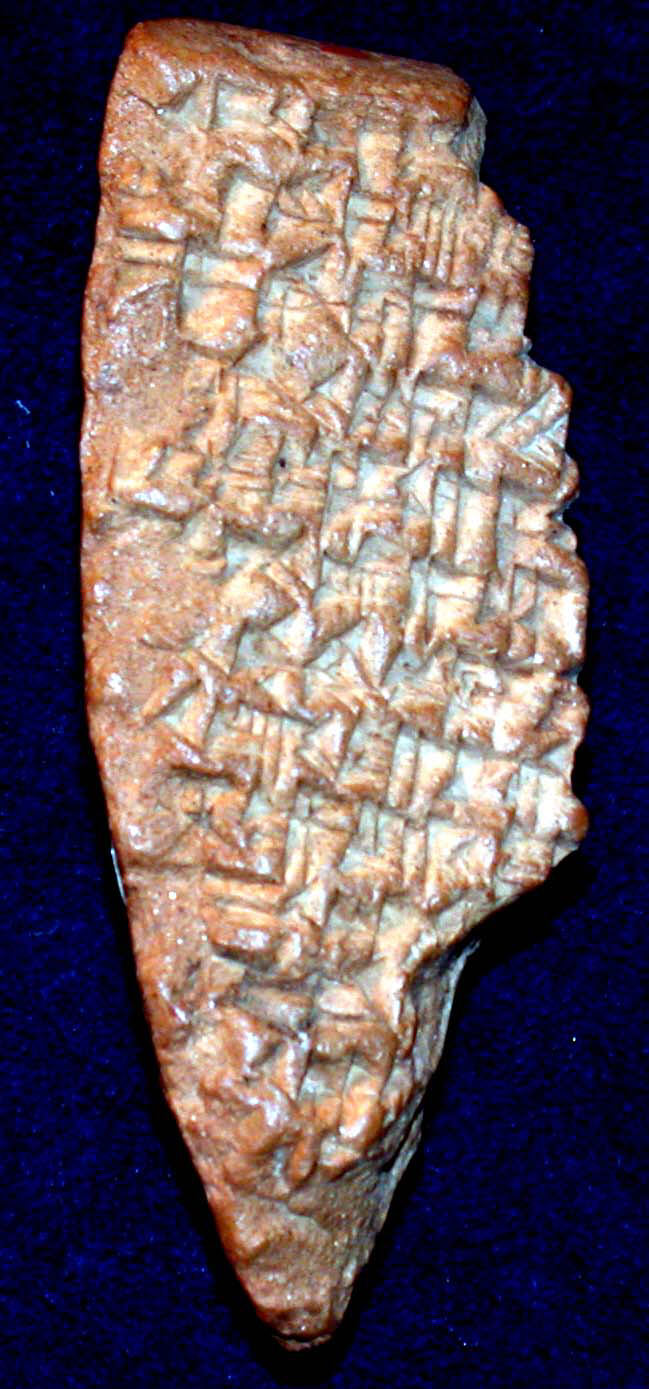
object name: cuneiform tablet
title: Cuneiform tablet: medical commentary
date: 333-1 BCE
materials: clay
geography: mesopotamia